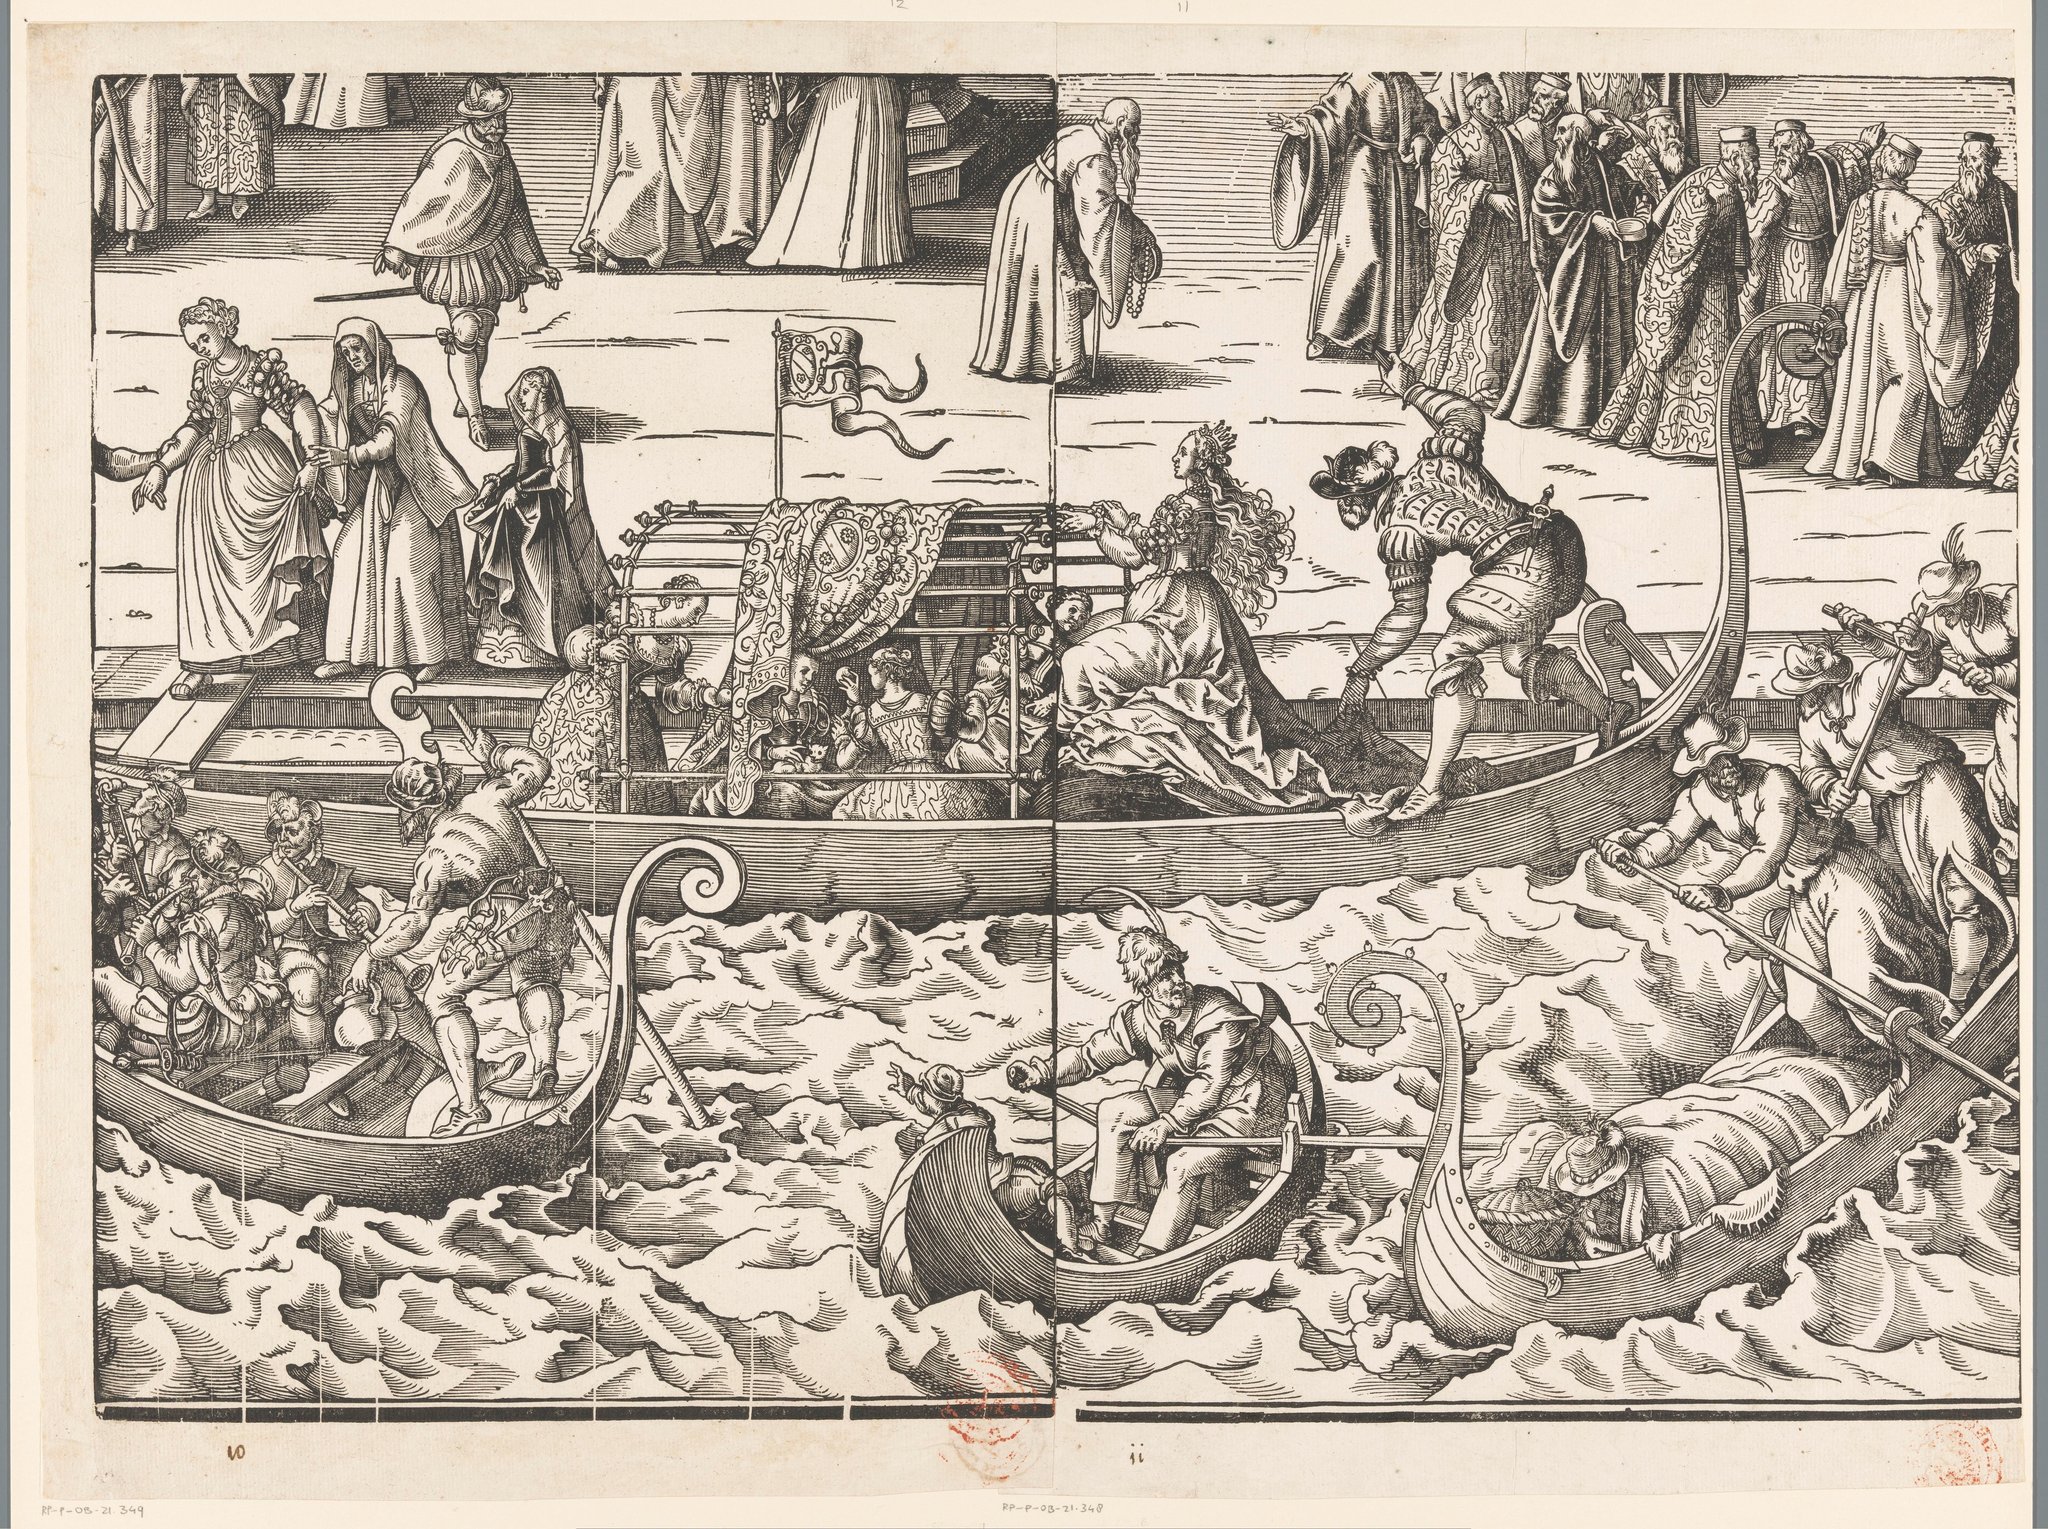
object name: print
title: Ankunfft Und herkommen der weitberümbten herrlichen Statt Venedig Sambt derselben gewaltigen Herrschafft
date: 1679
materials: paper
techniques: woodcut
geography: frankfurt am main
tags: fruits: apple, city-view in general; 'veduta', string instruments (bowed) - cc - out of doors, wind instruments - cc - out of doors, procession ~ christian religion, gondola, venice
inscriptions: collector's mark: Lugt 240, number: ‘10’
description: Twaalfde gedeelte van een grote voorstelling van de Festa della Sensa. De voorstelling is gedrukt van veertien blokken, de titel van vijf blokken en het onderschrift bestaat uit vijf delen van elk drie kolommen Duits tekst. De veertien blokken die samen de voorstelling vormen zijn in de titels met de klok mee vanaf linksboven genummerd. In de collectie Rijksmuseum bevinden zich twee complete exemplaren inclusief titel en onderschrift. Omdat niet alle delen van de titel en het onderschrift op afzonderlijke bladen zijn gedrukt, is dit exemplaar niet virtueel samengevoegd omwille van een betere presentatie. Zie voor het andere exemplaar: RP-P-2017-6073.